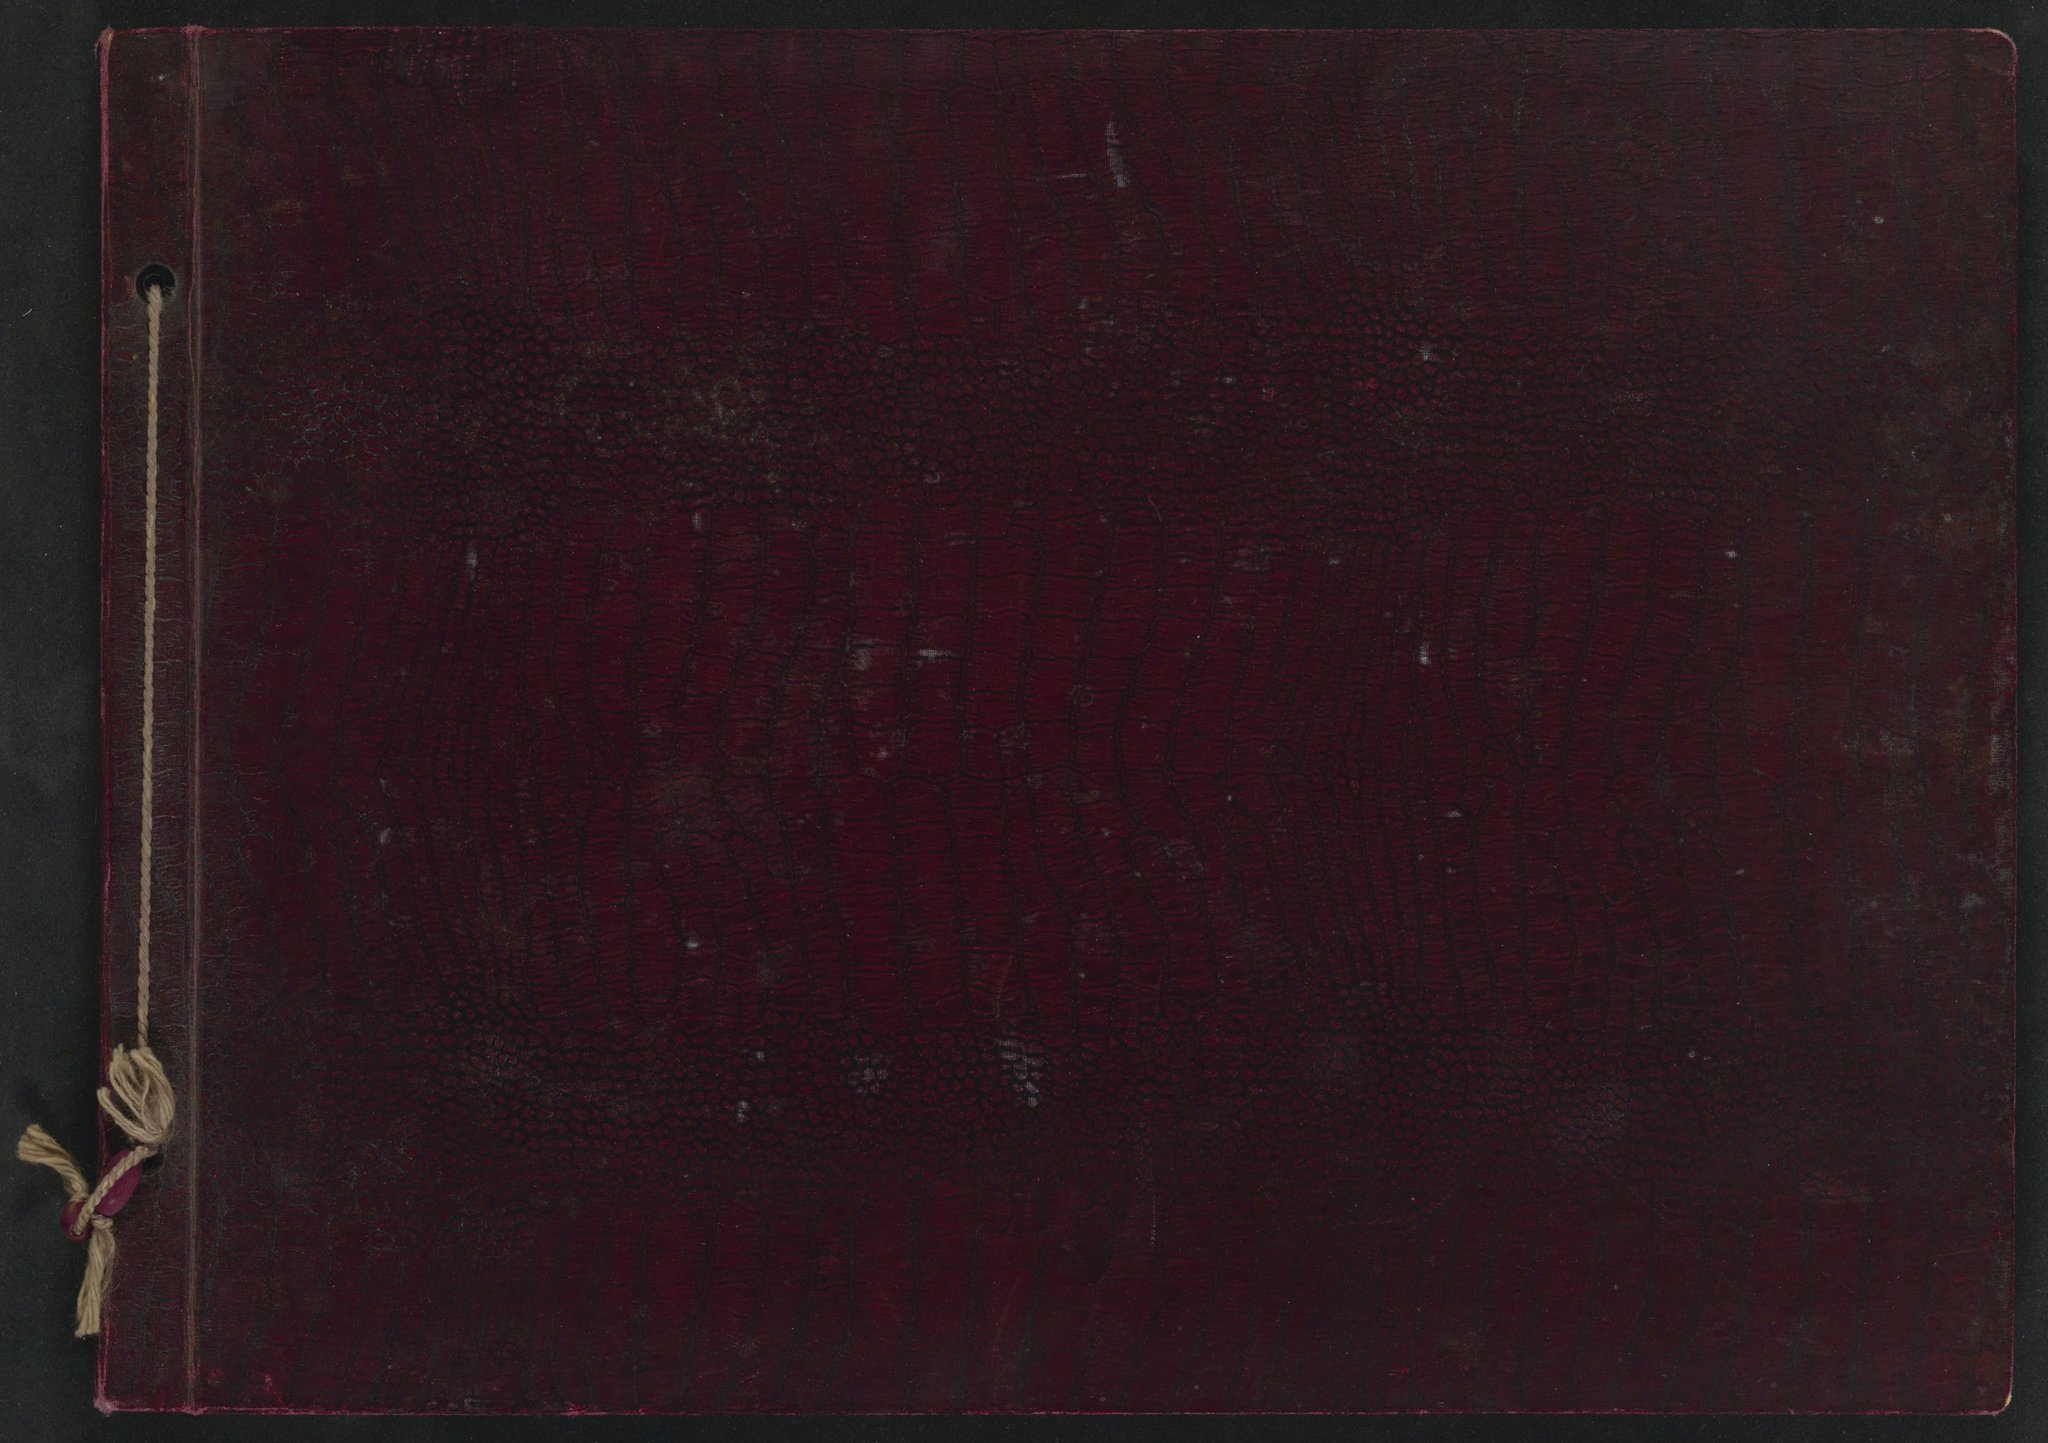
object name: photograph album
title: Album met foto's van Amsterdam en omgeving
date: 1900-1930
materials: cardboard, leather, metal, paper, photographic support, fiber, wood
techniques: gelatin silver print, rotogravure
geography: netherlands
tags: city-view, and landscape with man-made constructions, urban life, historical persons, village, outskirts of city, rural life, amsterdam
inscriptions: inscription: ‘L.M. Lammerse Kantoor-boekhandel Hoofdsteeg No. 41 Rotterdam’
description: Fotoalbum in bruine omslag van imitatieleer met een slangenhuidmotief. De bandrug is doorregen met een koord met twee houten kralen. Het album bevat 24 albumbladen gescheiden door groen pergamijn. Het zijn opnames van straten, huizen, poorten, parken, grachten, waterwerken in Amsterdam en destijds aangrenzende dorpen, zoals Durgerdam, Nieuwendam, Diemen, Sloten en Nieuwer-Amstel. Diverse foto's lijken opnieuw afgedrukt te zijn, de opnames zelf zijn mogelijk vóór 1900 gemaakt. De samensteller is onbekend maar zou een band kunnen hebben met het pand Eerste Helmersstraat 110 in Amsterdam, dat meerdere malen voorkomt in het album.